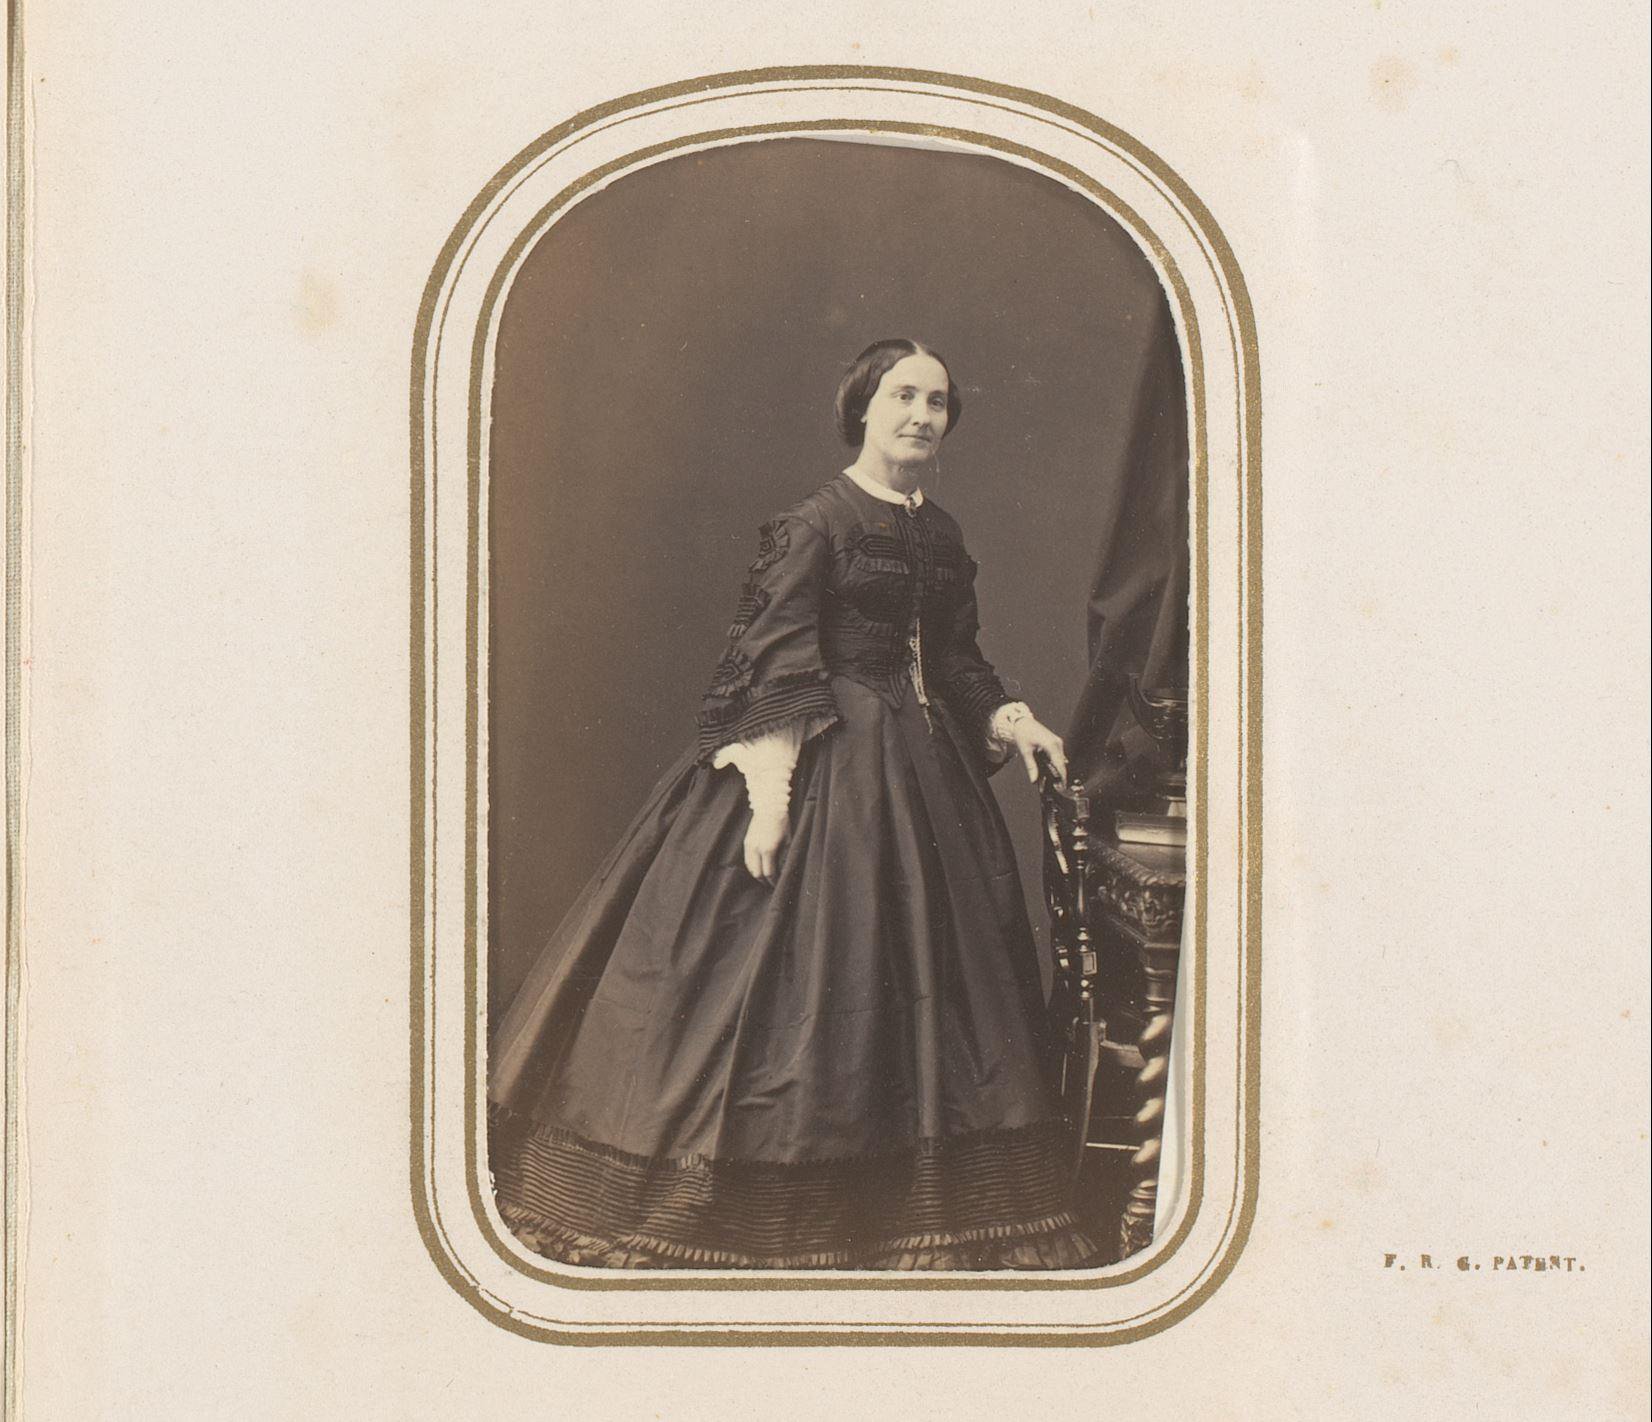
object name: photograph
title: Portret van een vrouw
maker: alexandre ken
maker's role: fotograaf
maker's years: 1828-1874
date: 1850-1874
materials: cardboard, photographic support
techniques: albumen print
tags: historical persons, standing figure - aa - female human figure, dress, gown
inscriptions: inscription: ‘A. Ken/ Photographe/ Boulevt Montmartre 10/ Paris’